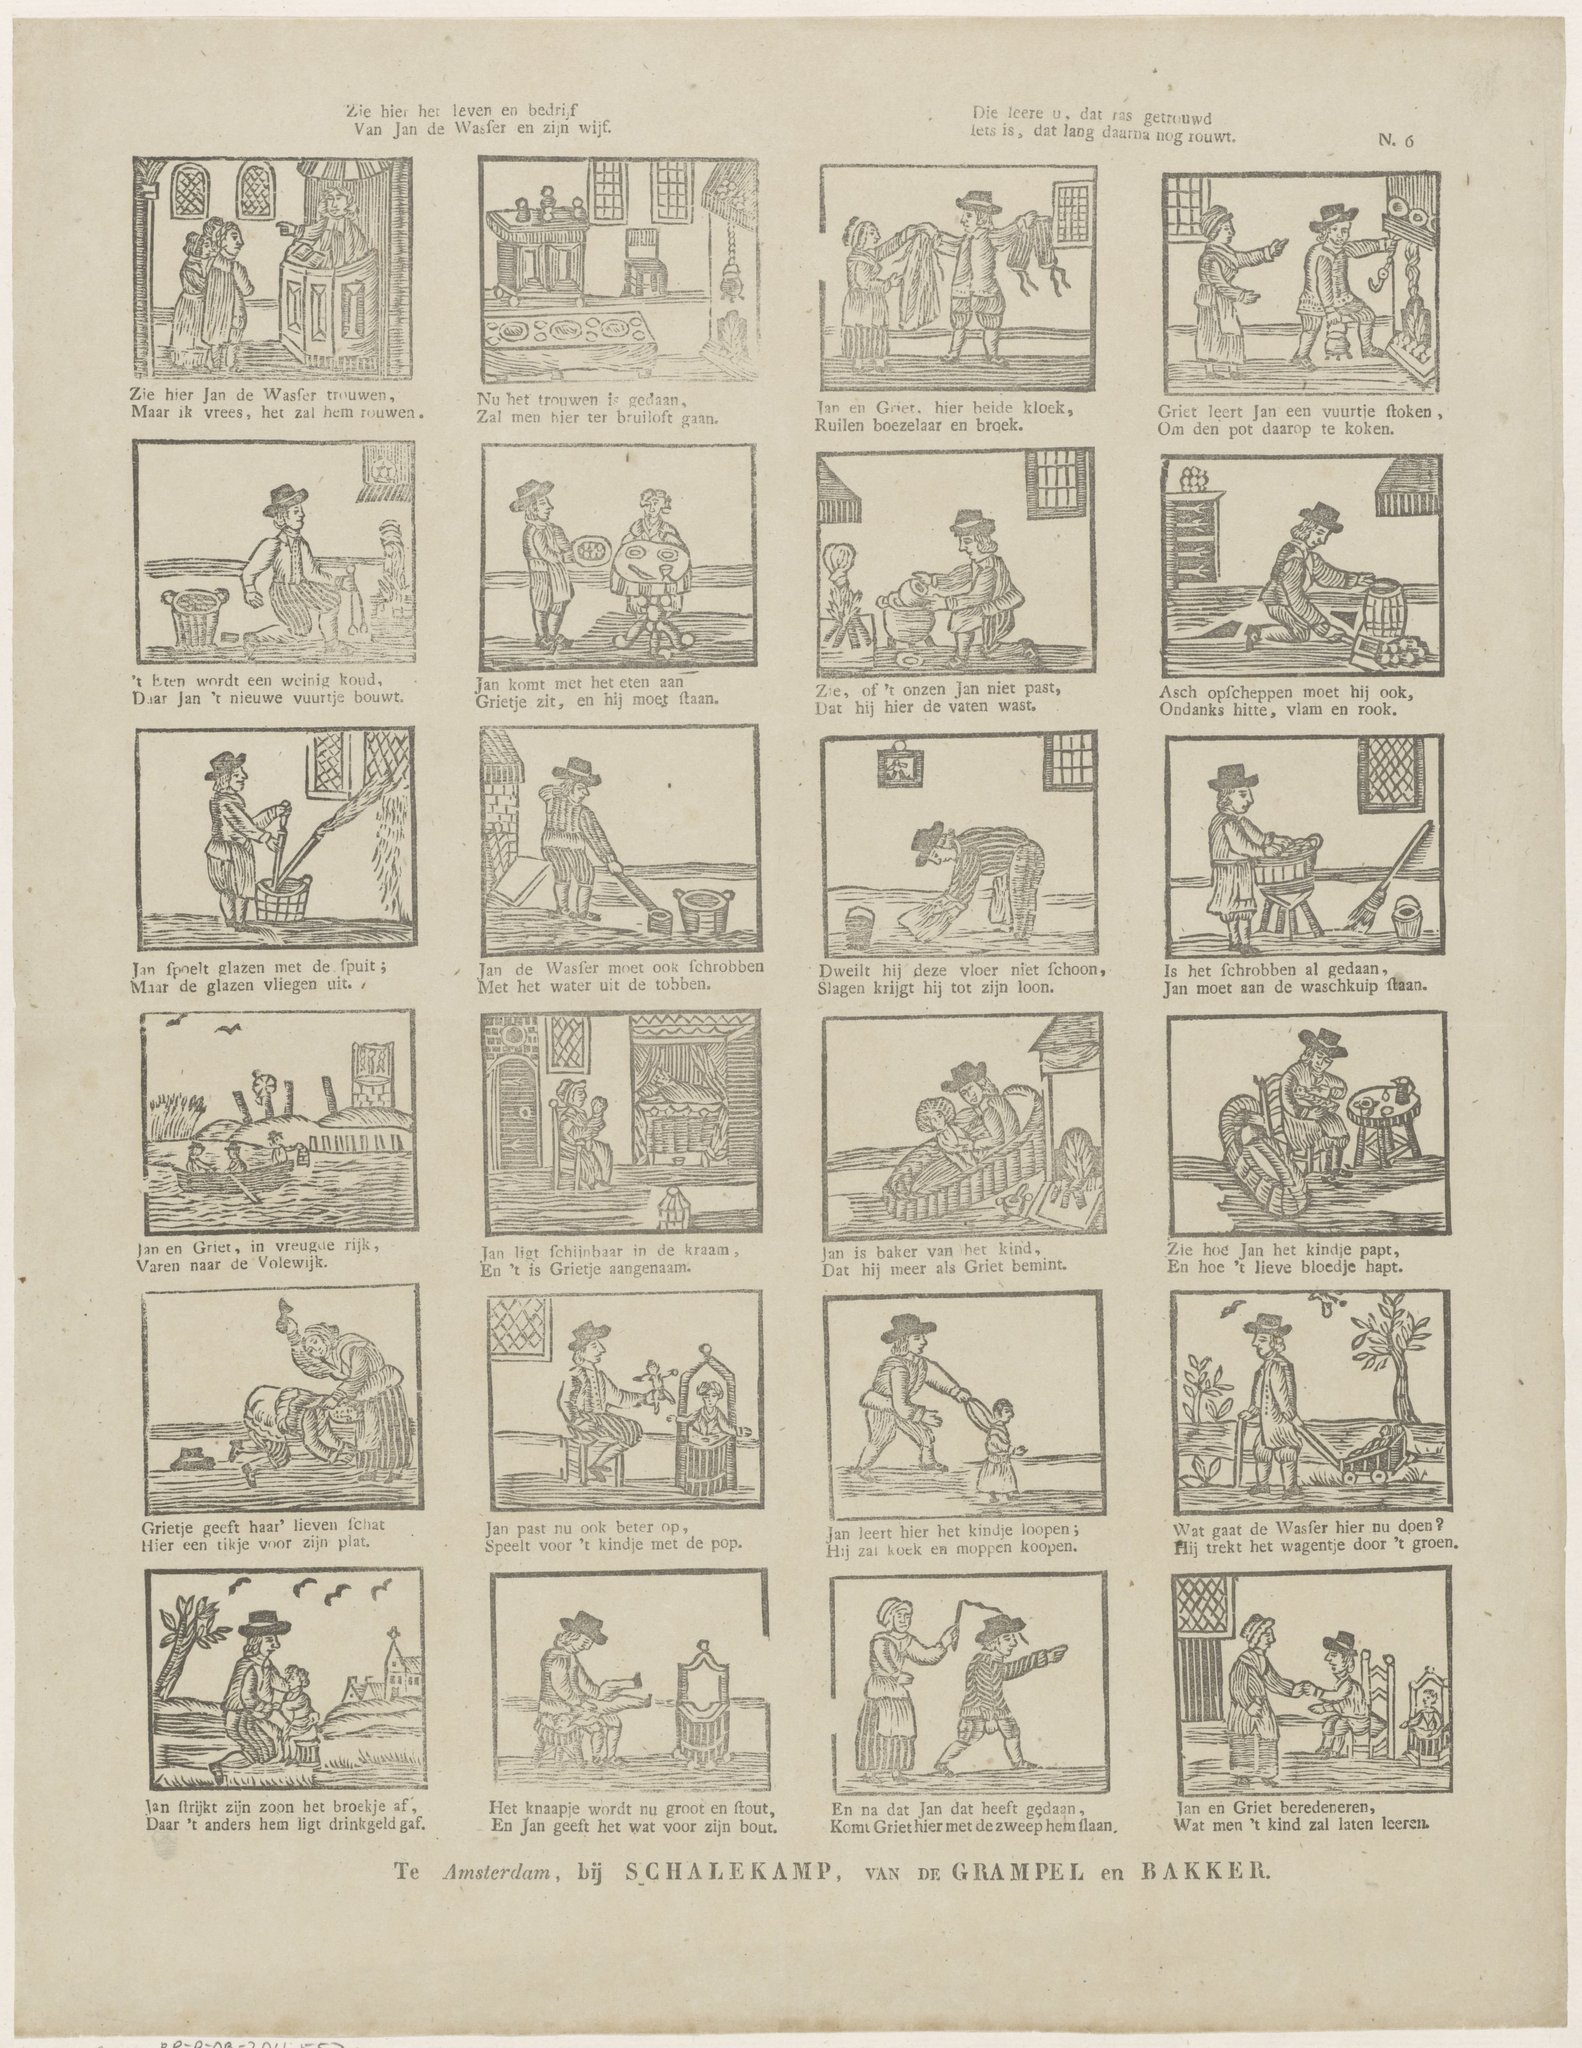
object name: print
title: Zie hier het leven en bedrijf / Van Jan de Wasser en zijn wijf. / Die leere u, dat ras getrouwd / Iets is, dat lang daarna nog rouwt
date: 1822-1849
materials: paper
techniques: letterpress printing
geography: deventer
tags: hen-pecked husband, 'betty', 'molly' (man who engages in women's work)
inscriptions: collector's mark: Lugt 2760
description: Blad met 24 voorstellingen uit het leven van Jan de Wasser, een man die van zijn vrouw Griet, die de broek aan heeft, al het huishoudelijk werk moet doen. Onder elke afbeelding een tweeregelig vers. Genummerd rechtsboven: N. 6.